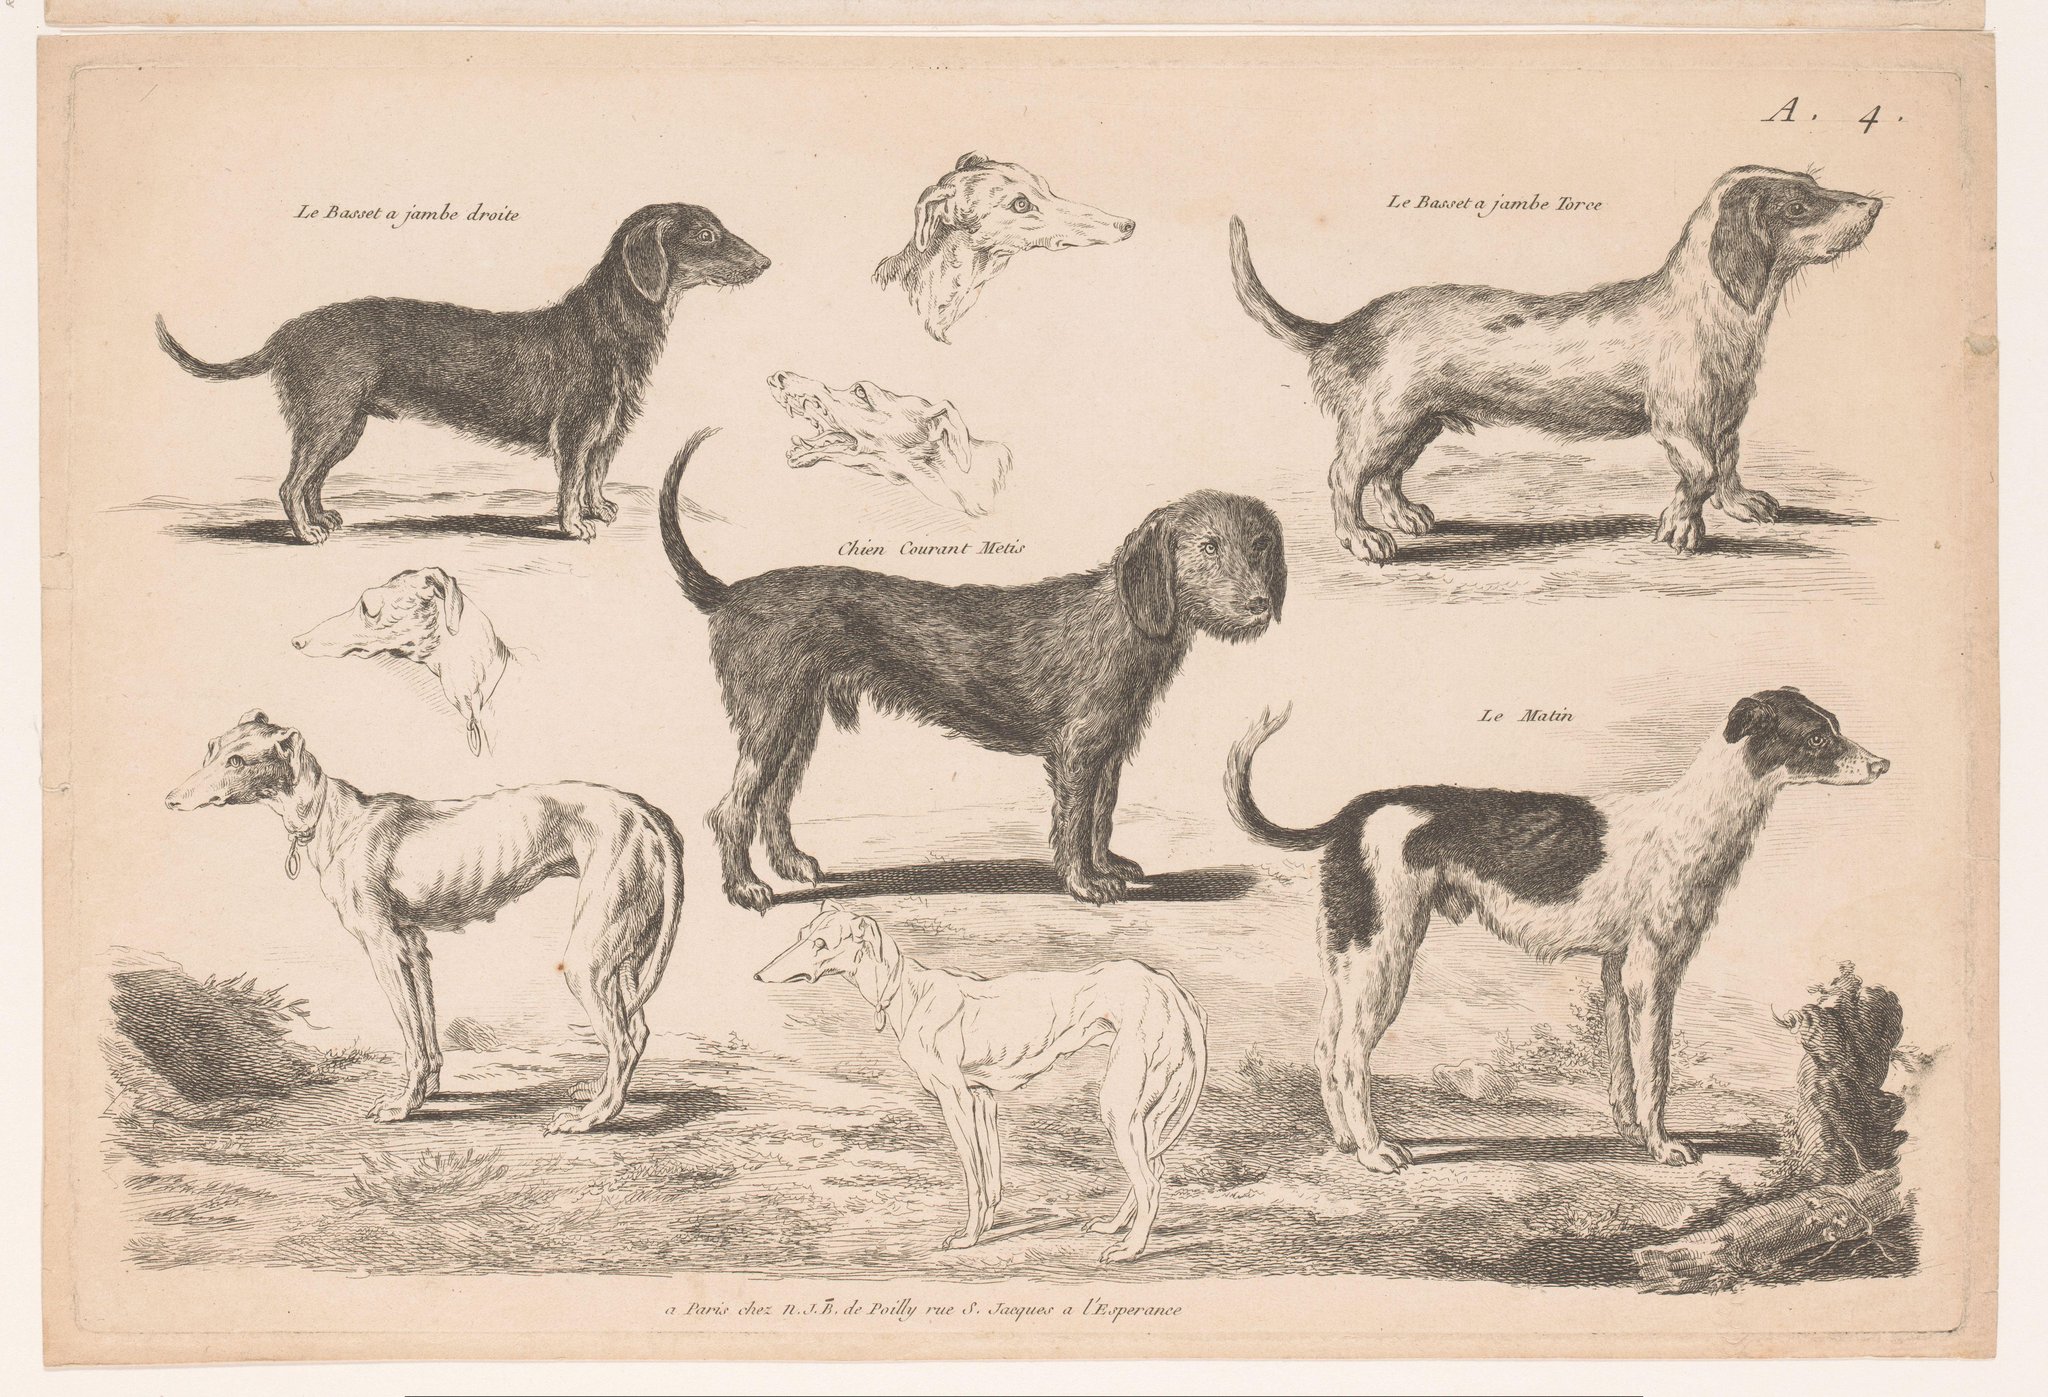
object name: print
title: Verschillende hondenrassen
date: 1750-1820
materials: paper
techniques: engraving, etching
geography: paris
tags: dog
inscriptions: watermark, collector's mark: Lugt 2228